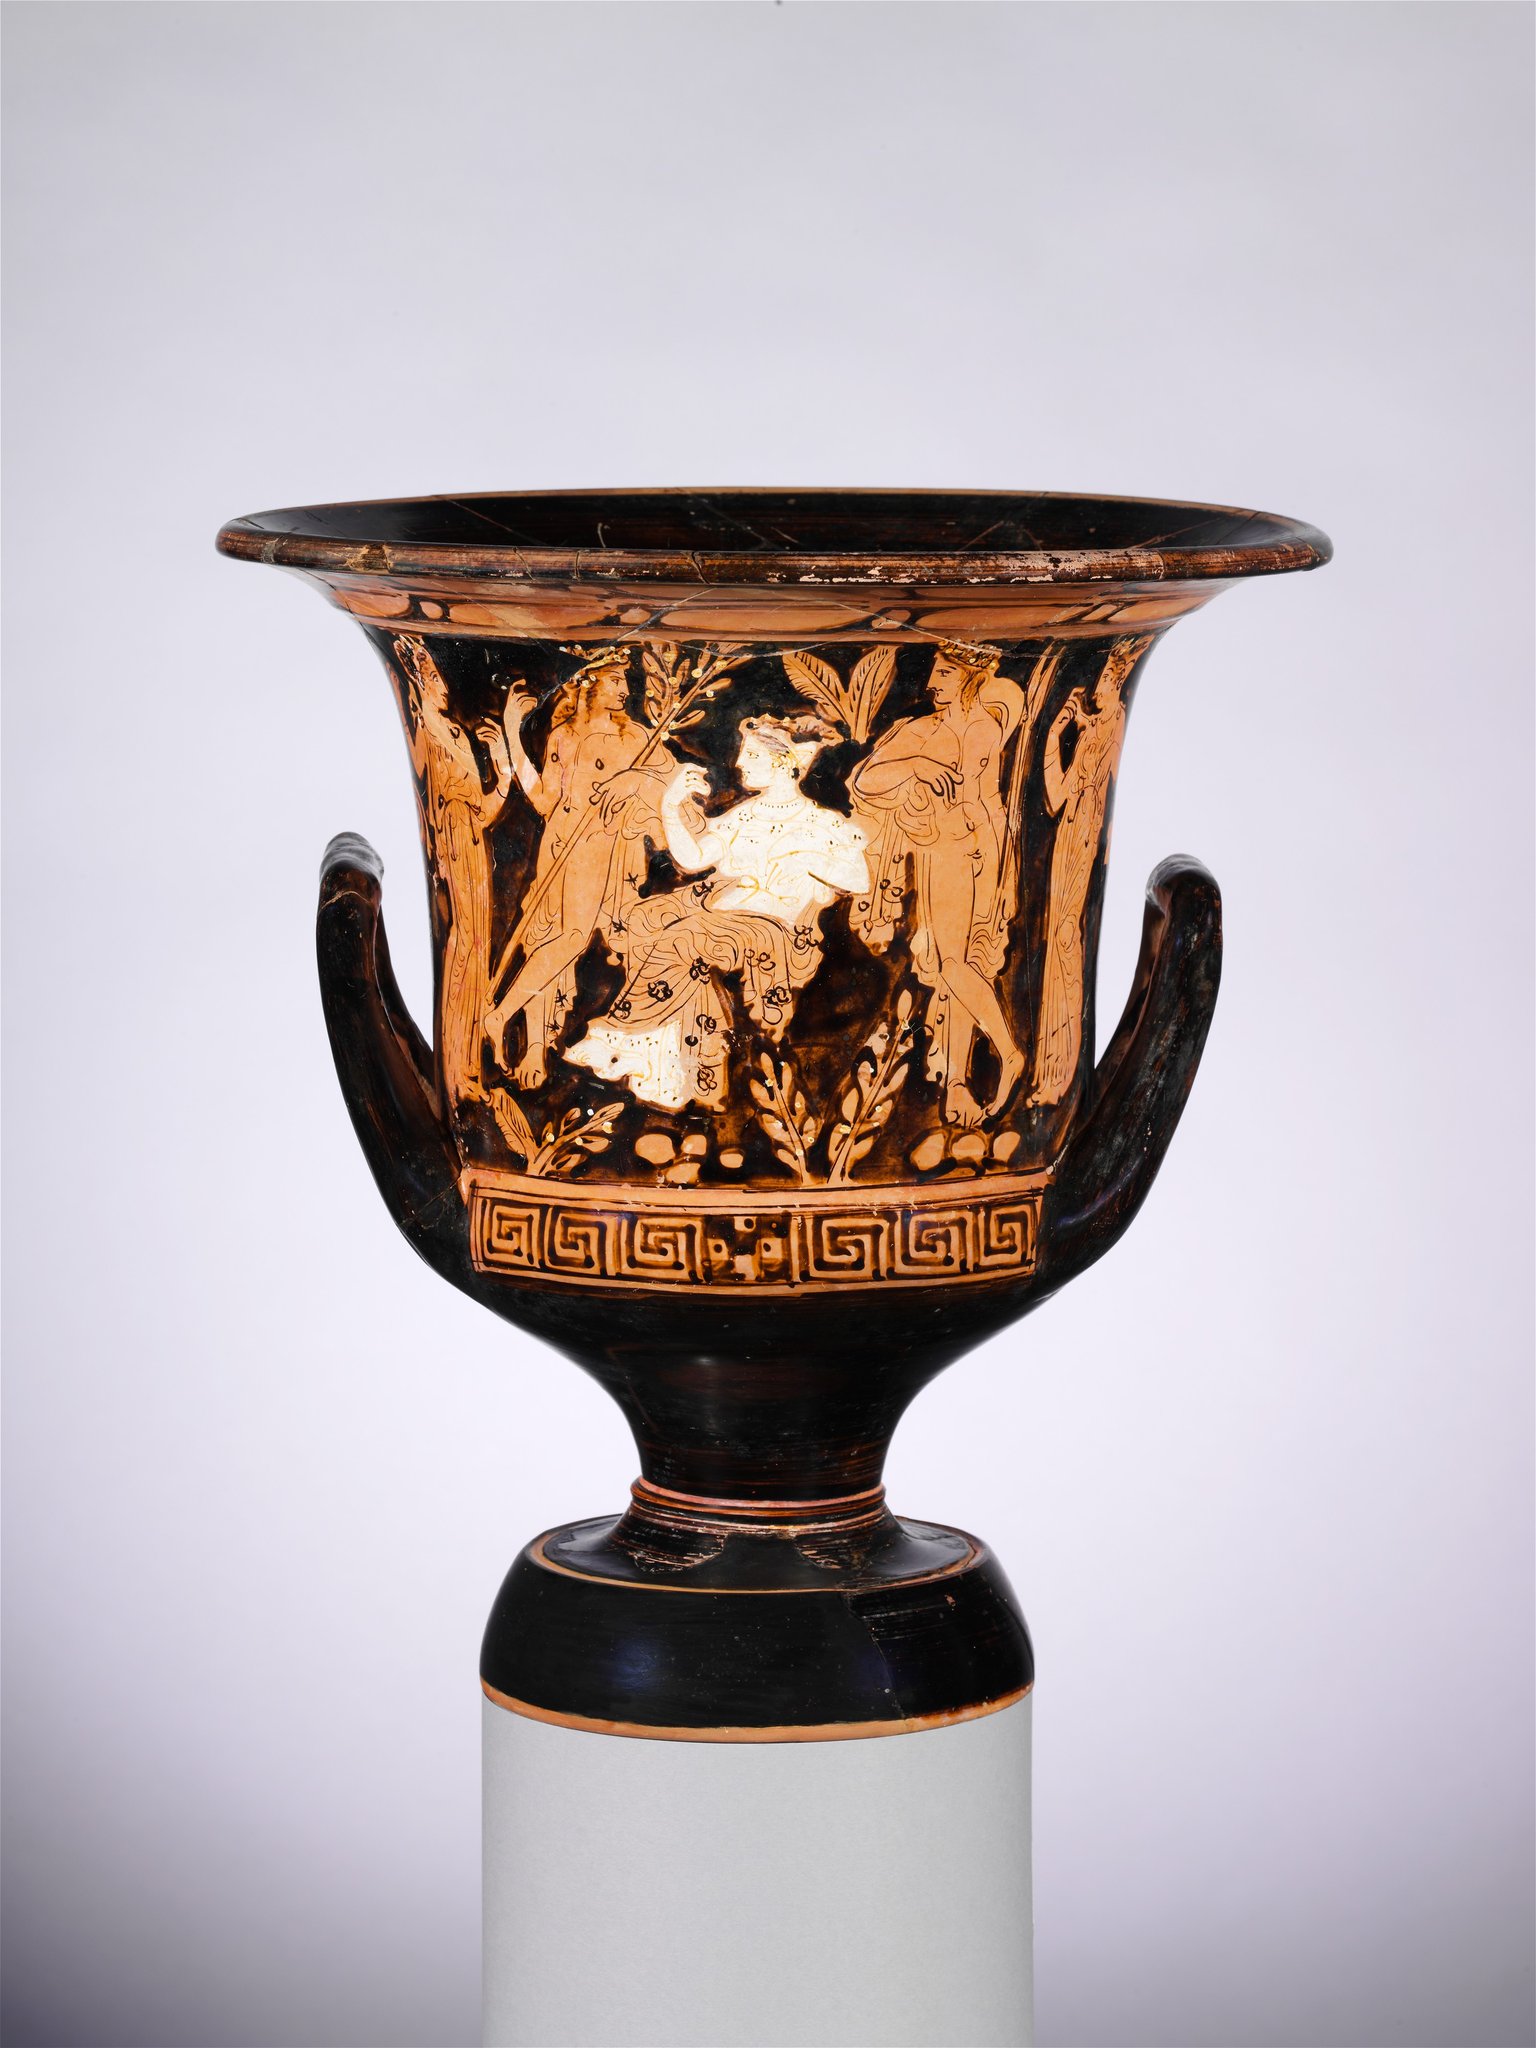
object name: calyx krater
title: Terracotta calyx-krater (bowl for mixing wine and water)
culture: greek, attic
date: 400-368 BCE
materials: terracotta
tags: men,women,ariadne